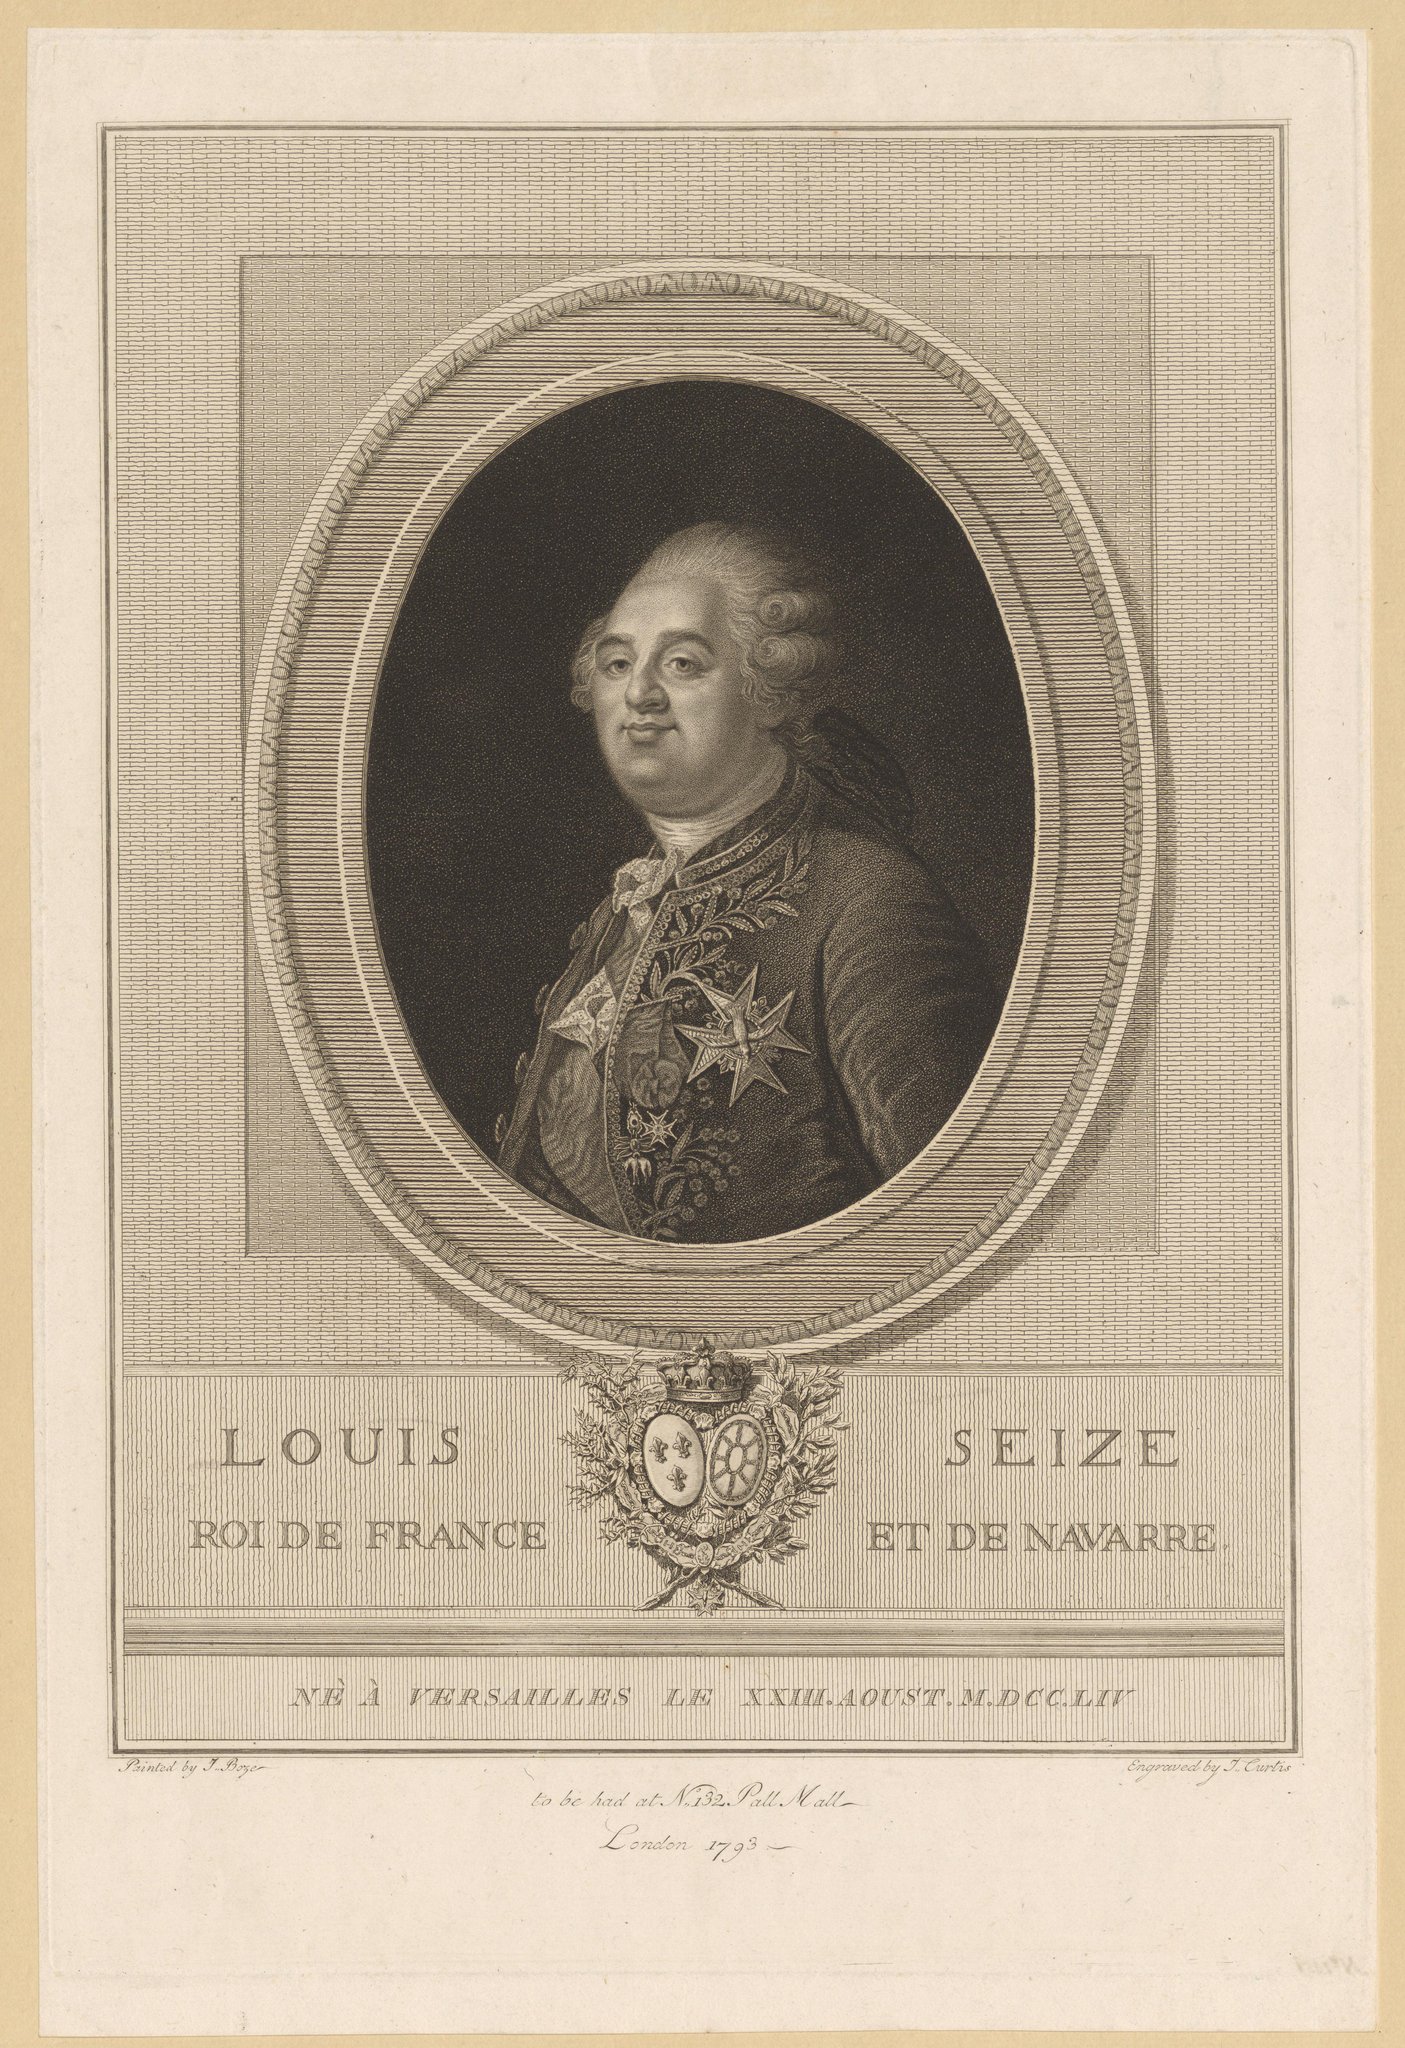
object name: print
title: Louis Seize Roi de France et de Navarre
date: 1793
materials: paper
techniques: etching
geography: england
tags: paris, lodewijk xvi (koning van frankrijk), historical persons, king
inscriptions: collector's mark: Lugt 2228